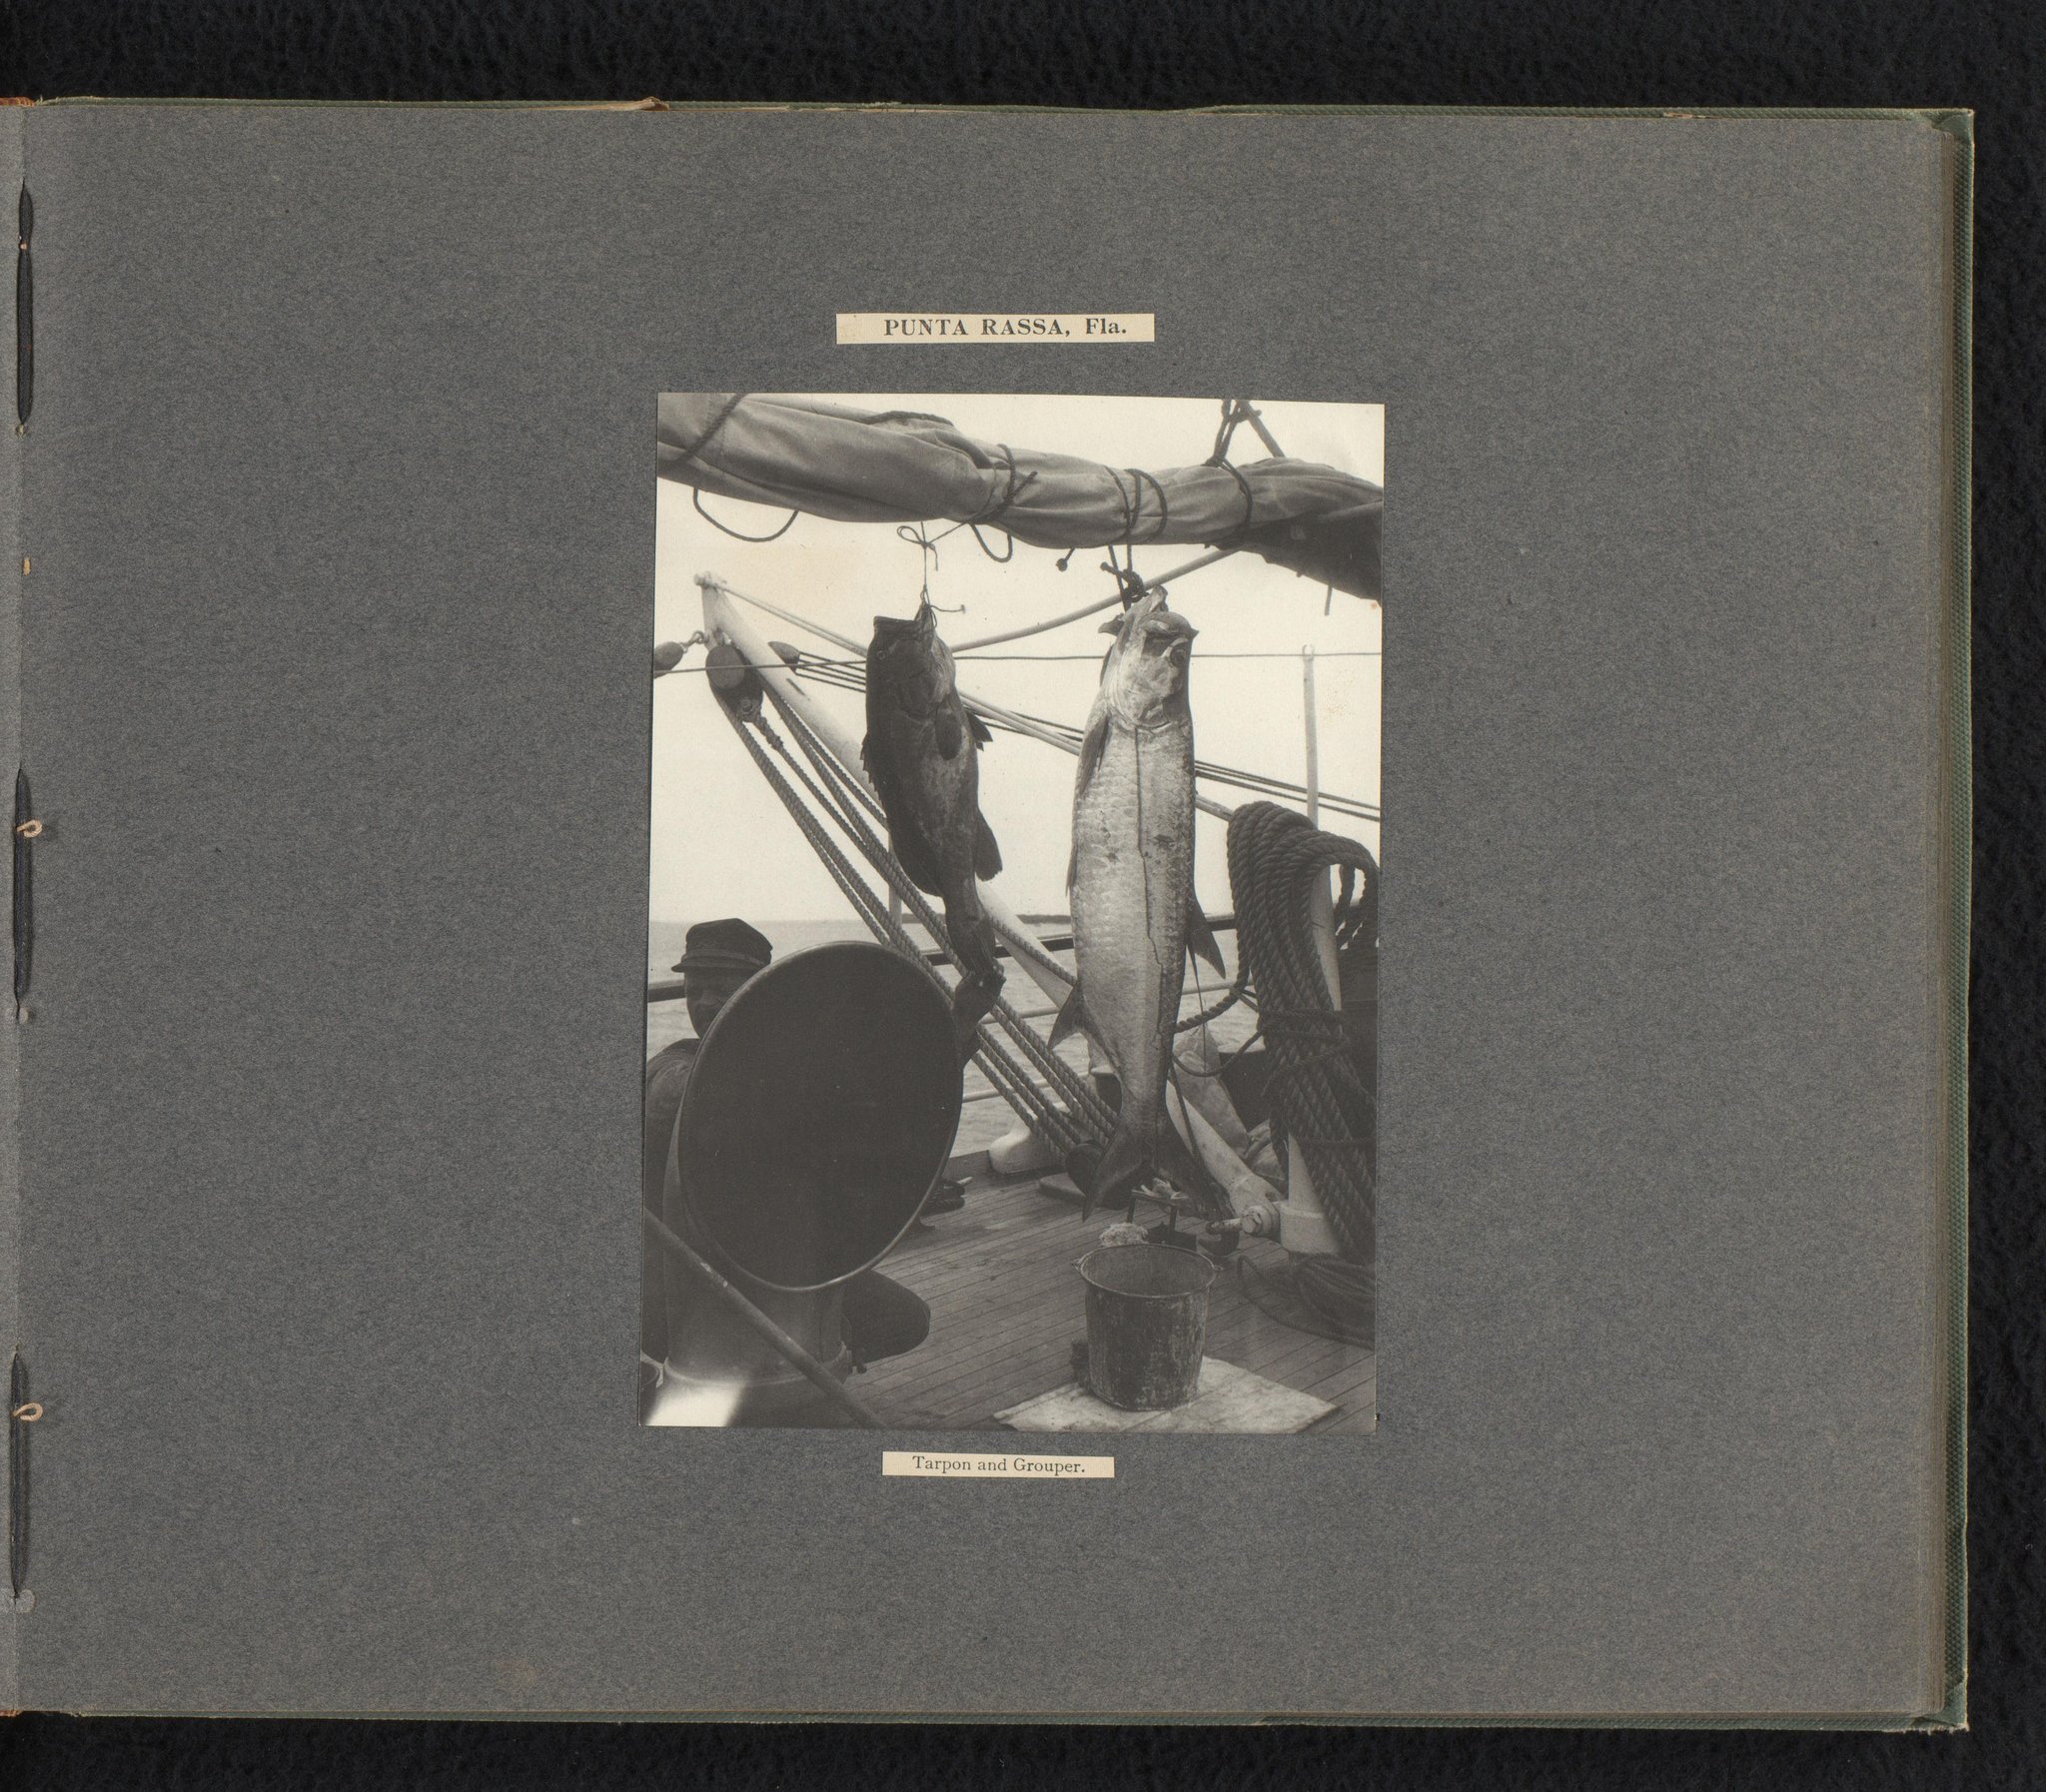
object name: album leaf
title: Tarpon en zeebaars hangend aan een mast van de Columbia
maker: Anonymous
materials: paper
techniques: platinum process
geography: florida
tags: fishes, fishing (sports)